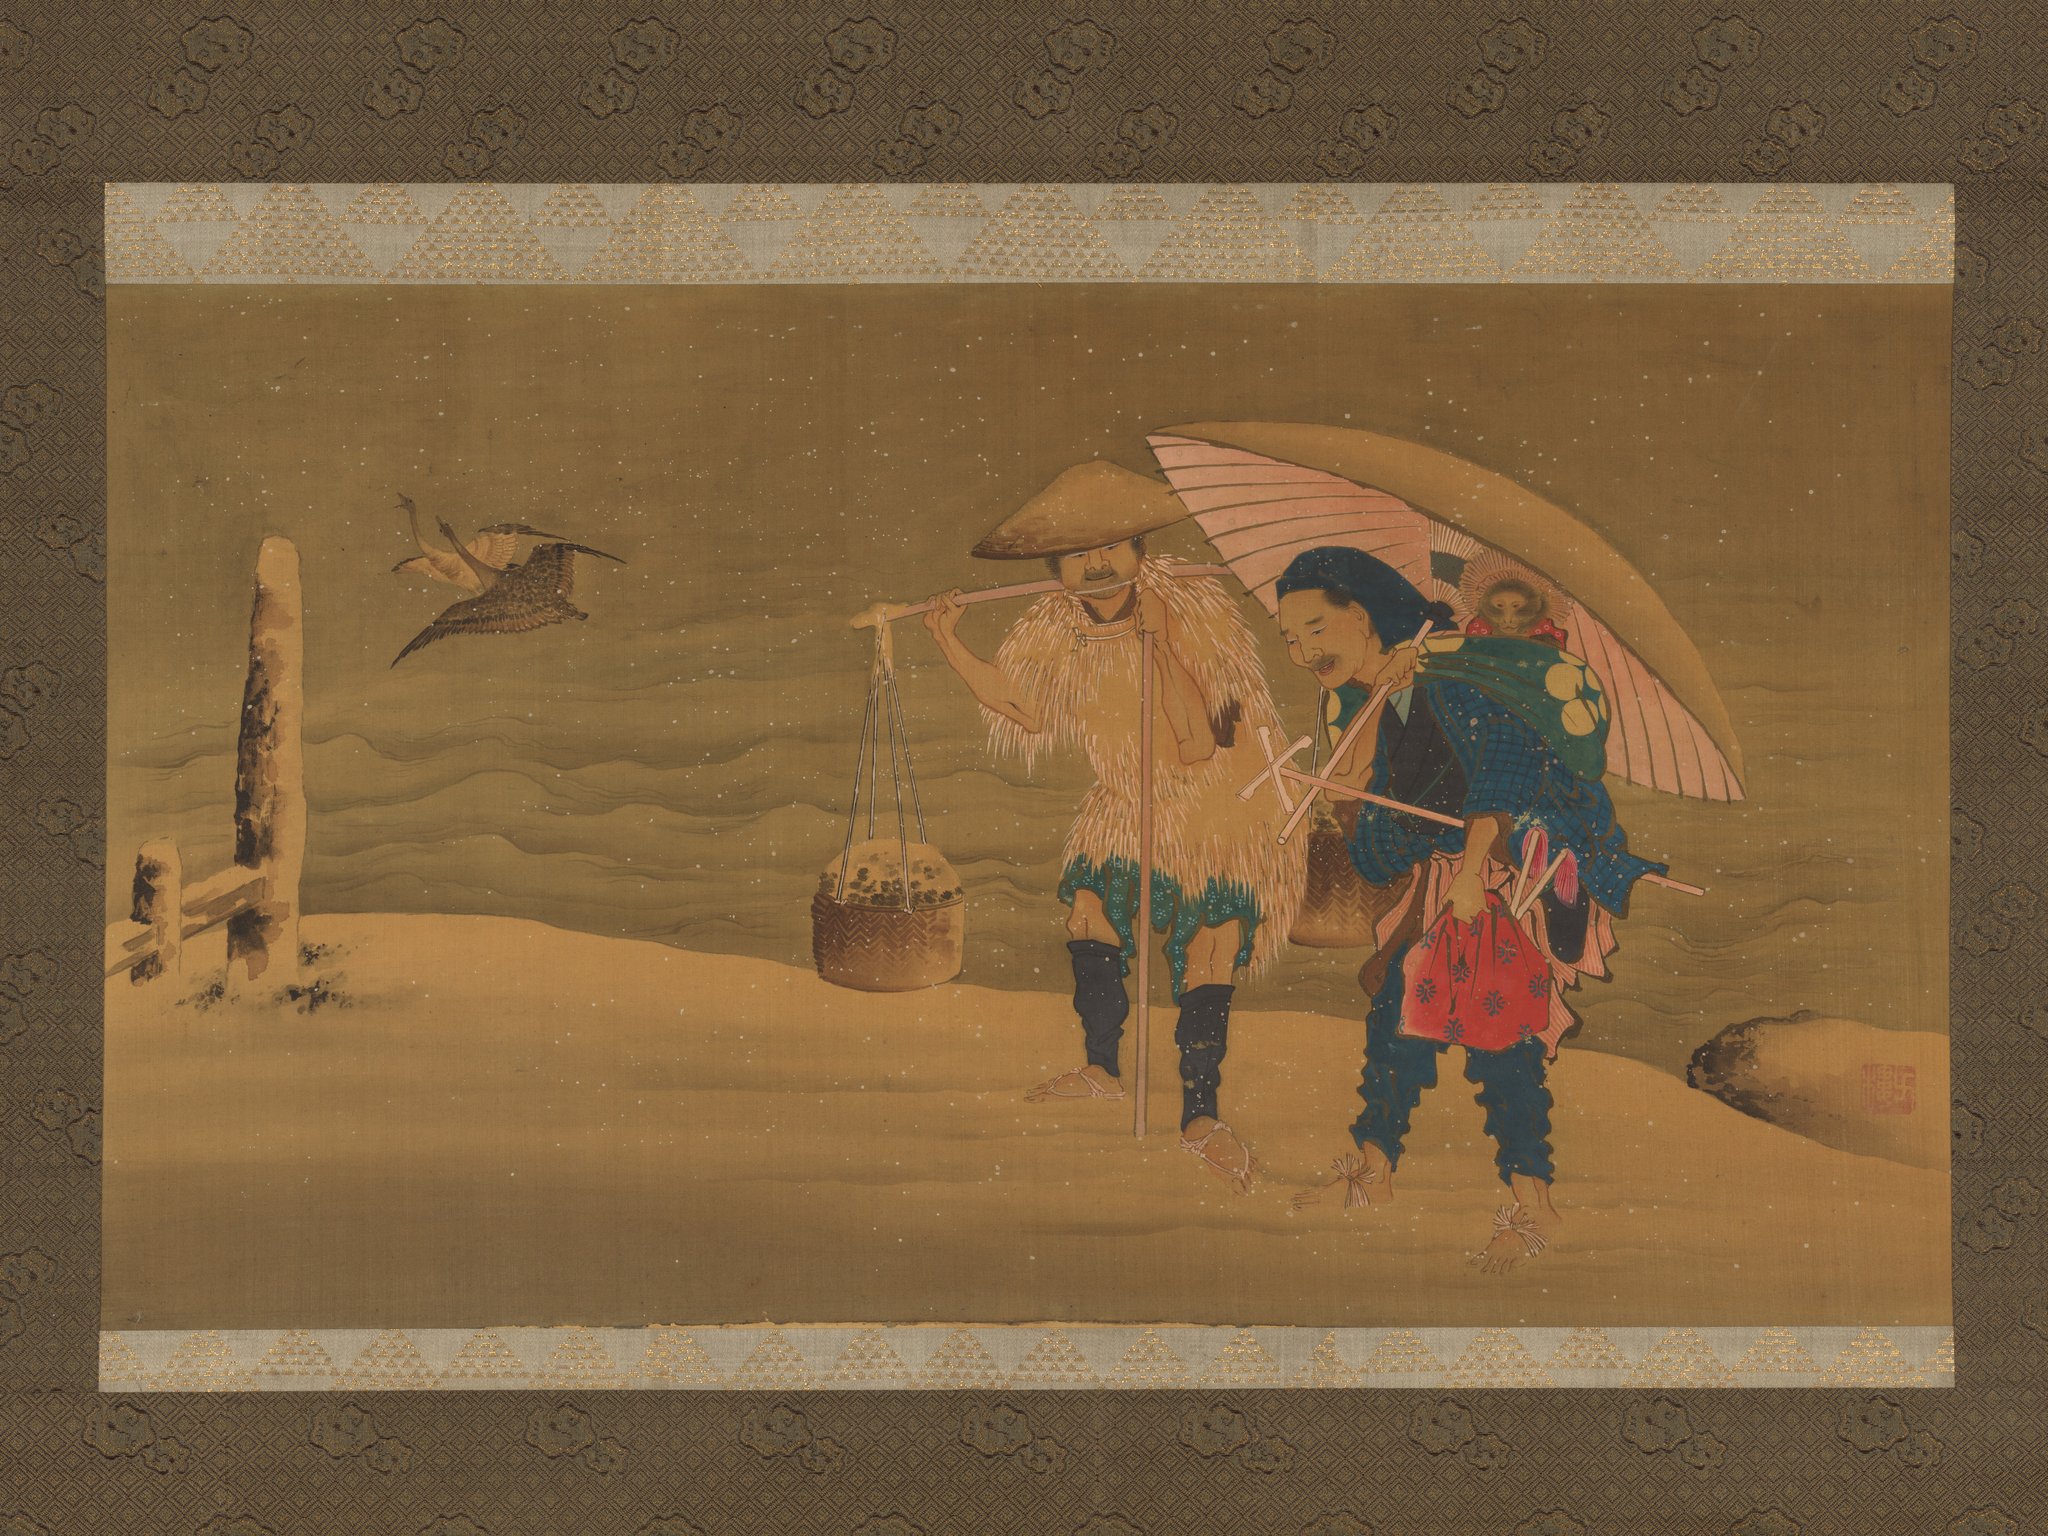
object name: hanging scroll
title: Monkey Showman and Porter(?) in the Snow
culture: japanese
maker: hokuga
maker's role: artist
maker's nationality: japanese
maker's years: 1800-1835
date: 1801-1900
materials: ink, silk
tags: geese,men,monkeys,snow,umbrellas